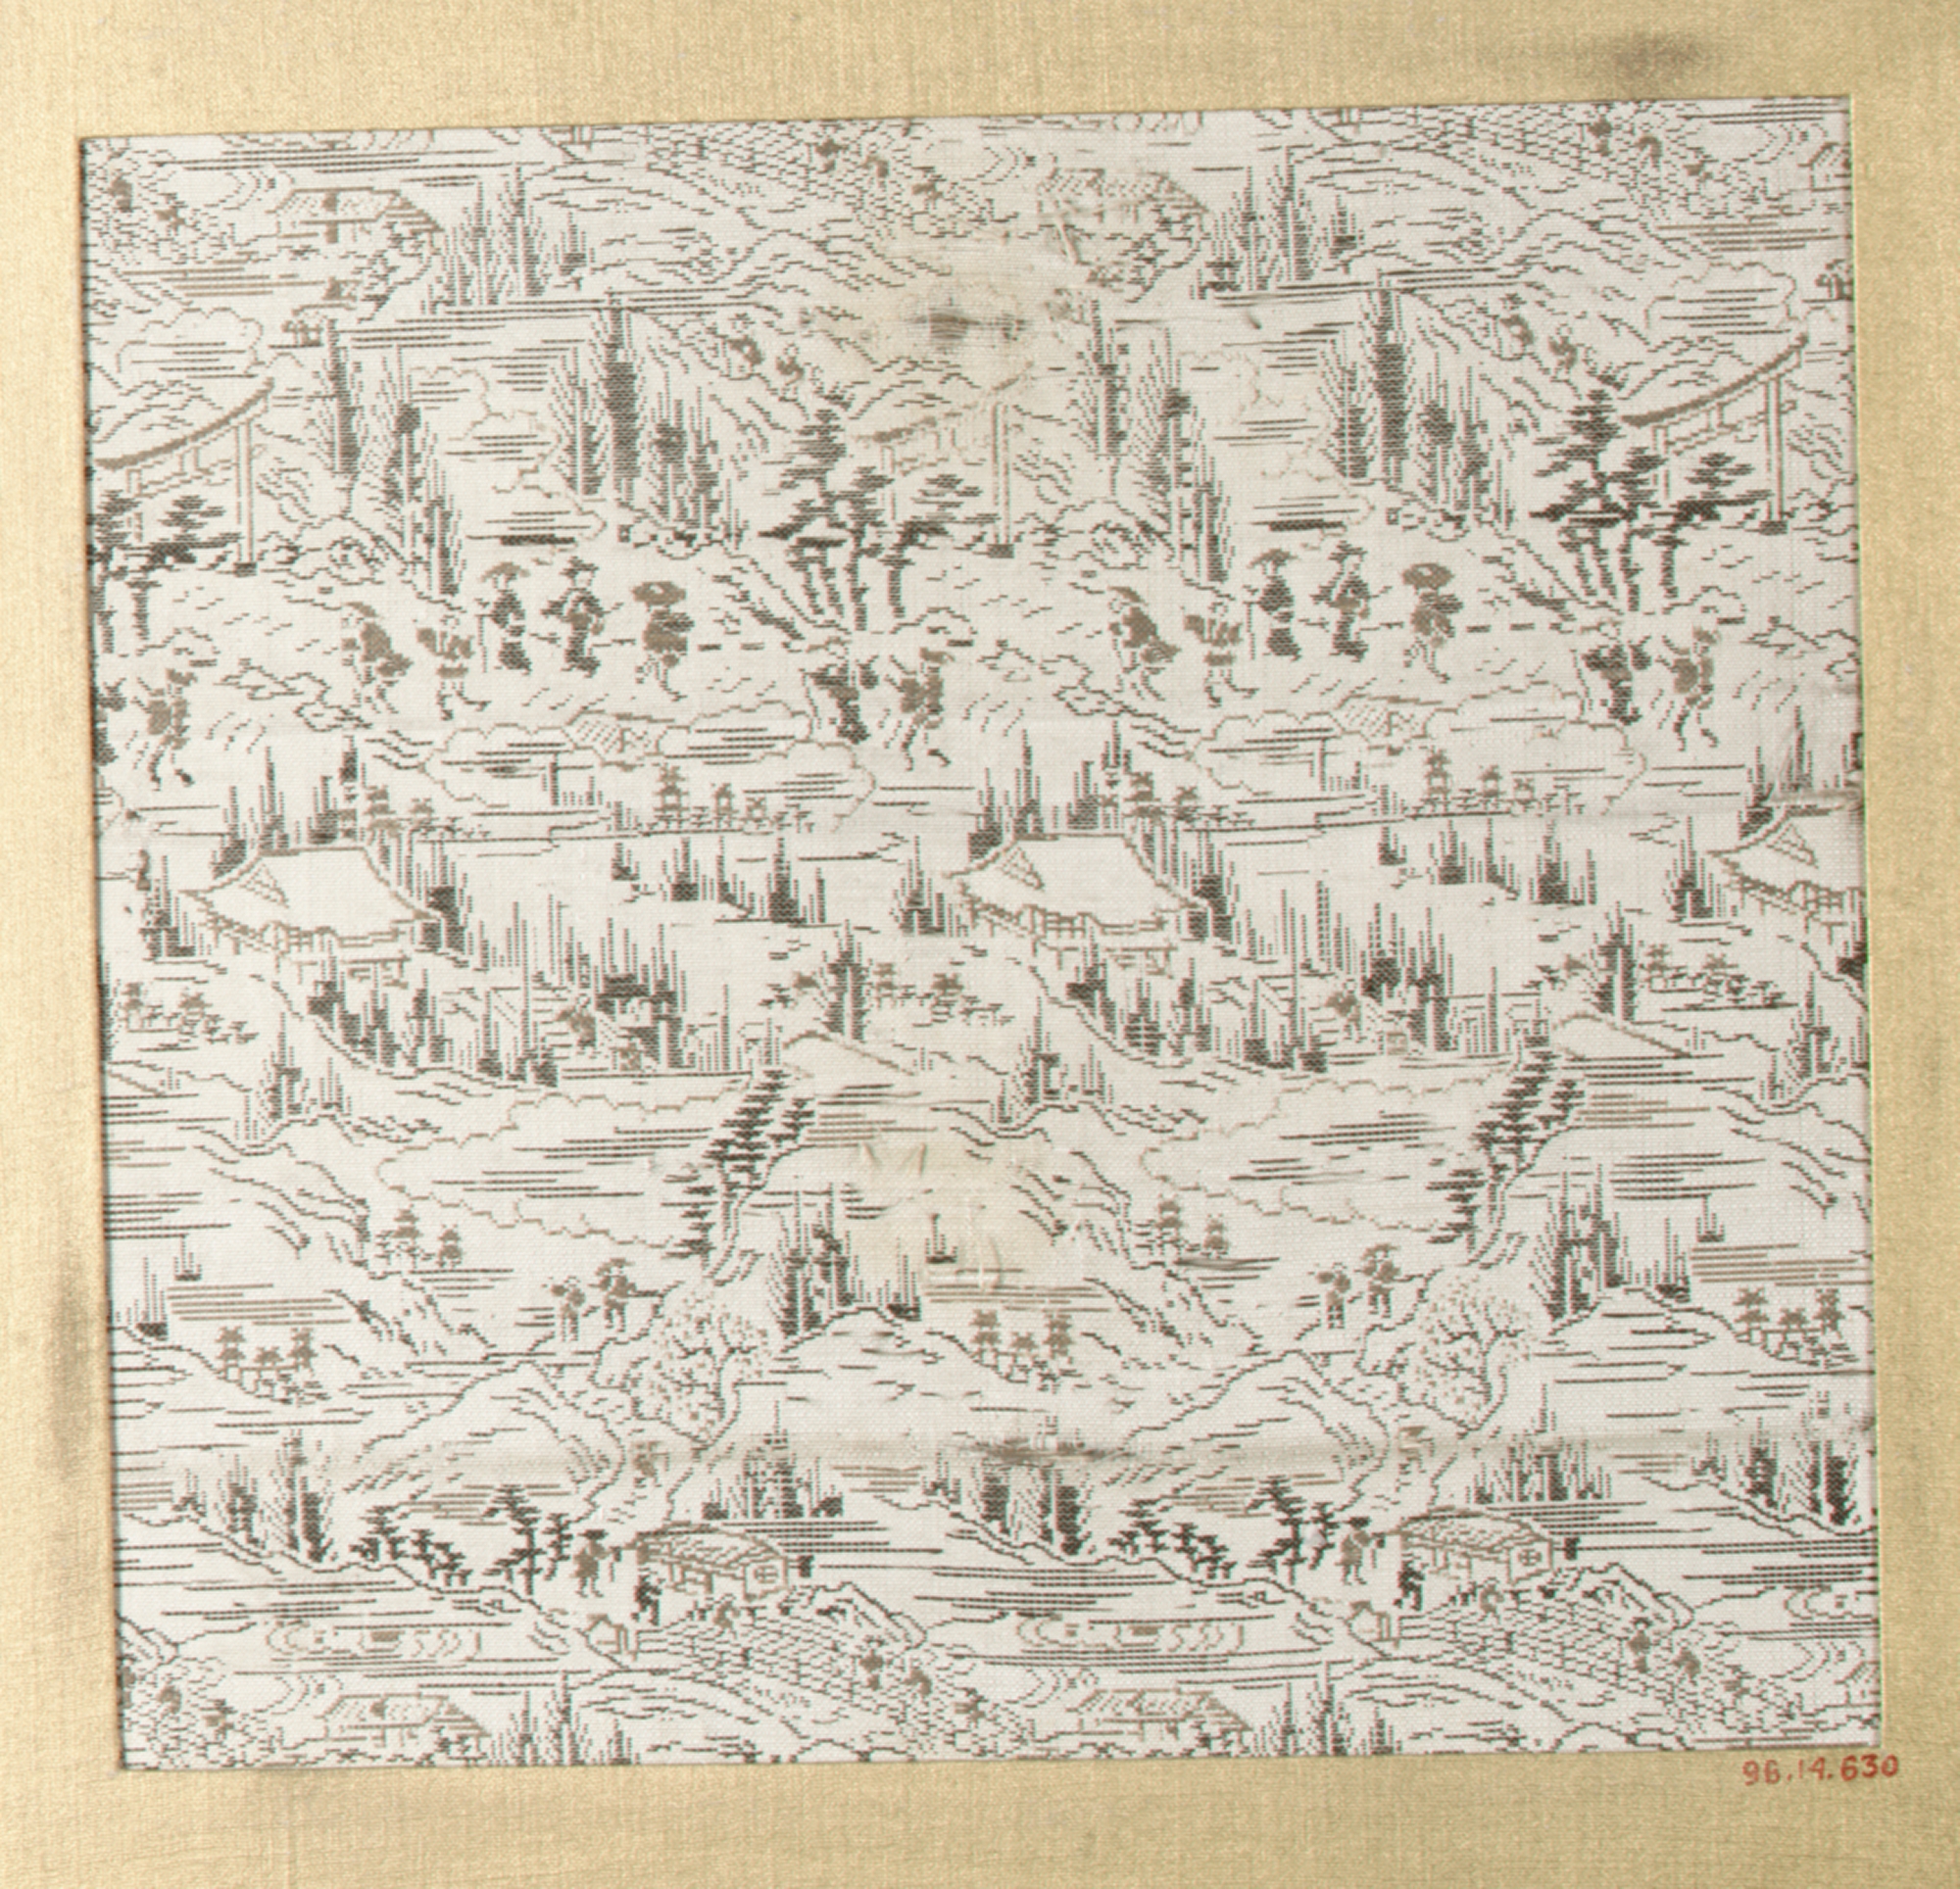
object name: piece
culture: japanese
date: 1701-1900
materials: silk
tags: human figures,trees